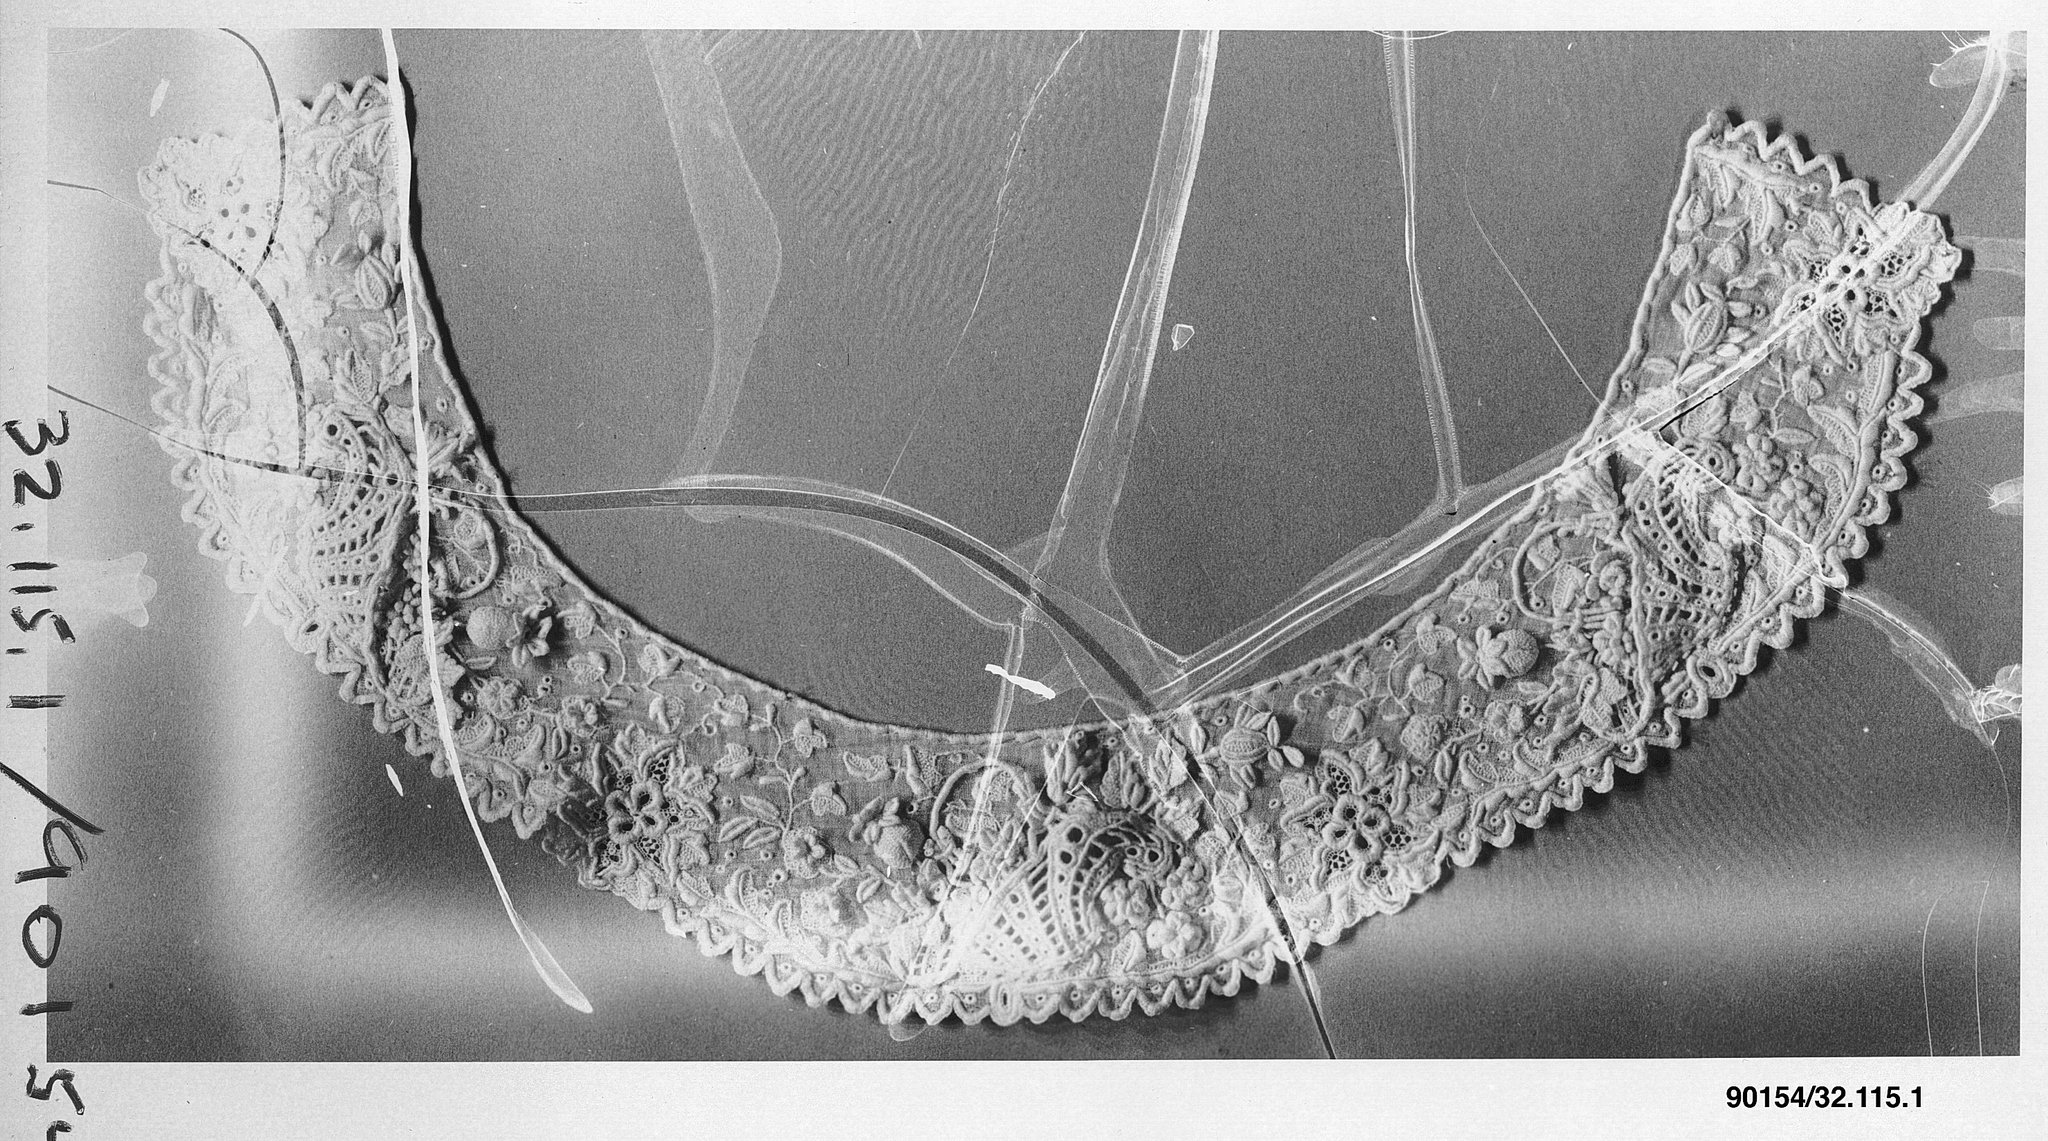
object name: collar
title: Collar (part of a set)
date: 1801-1900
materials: cotton